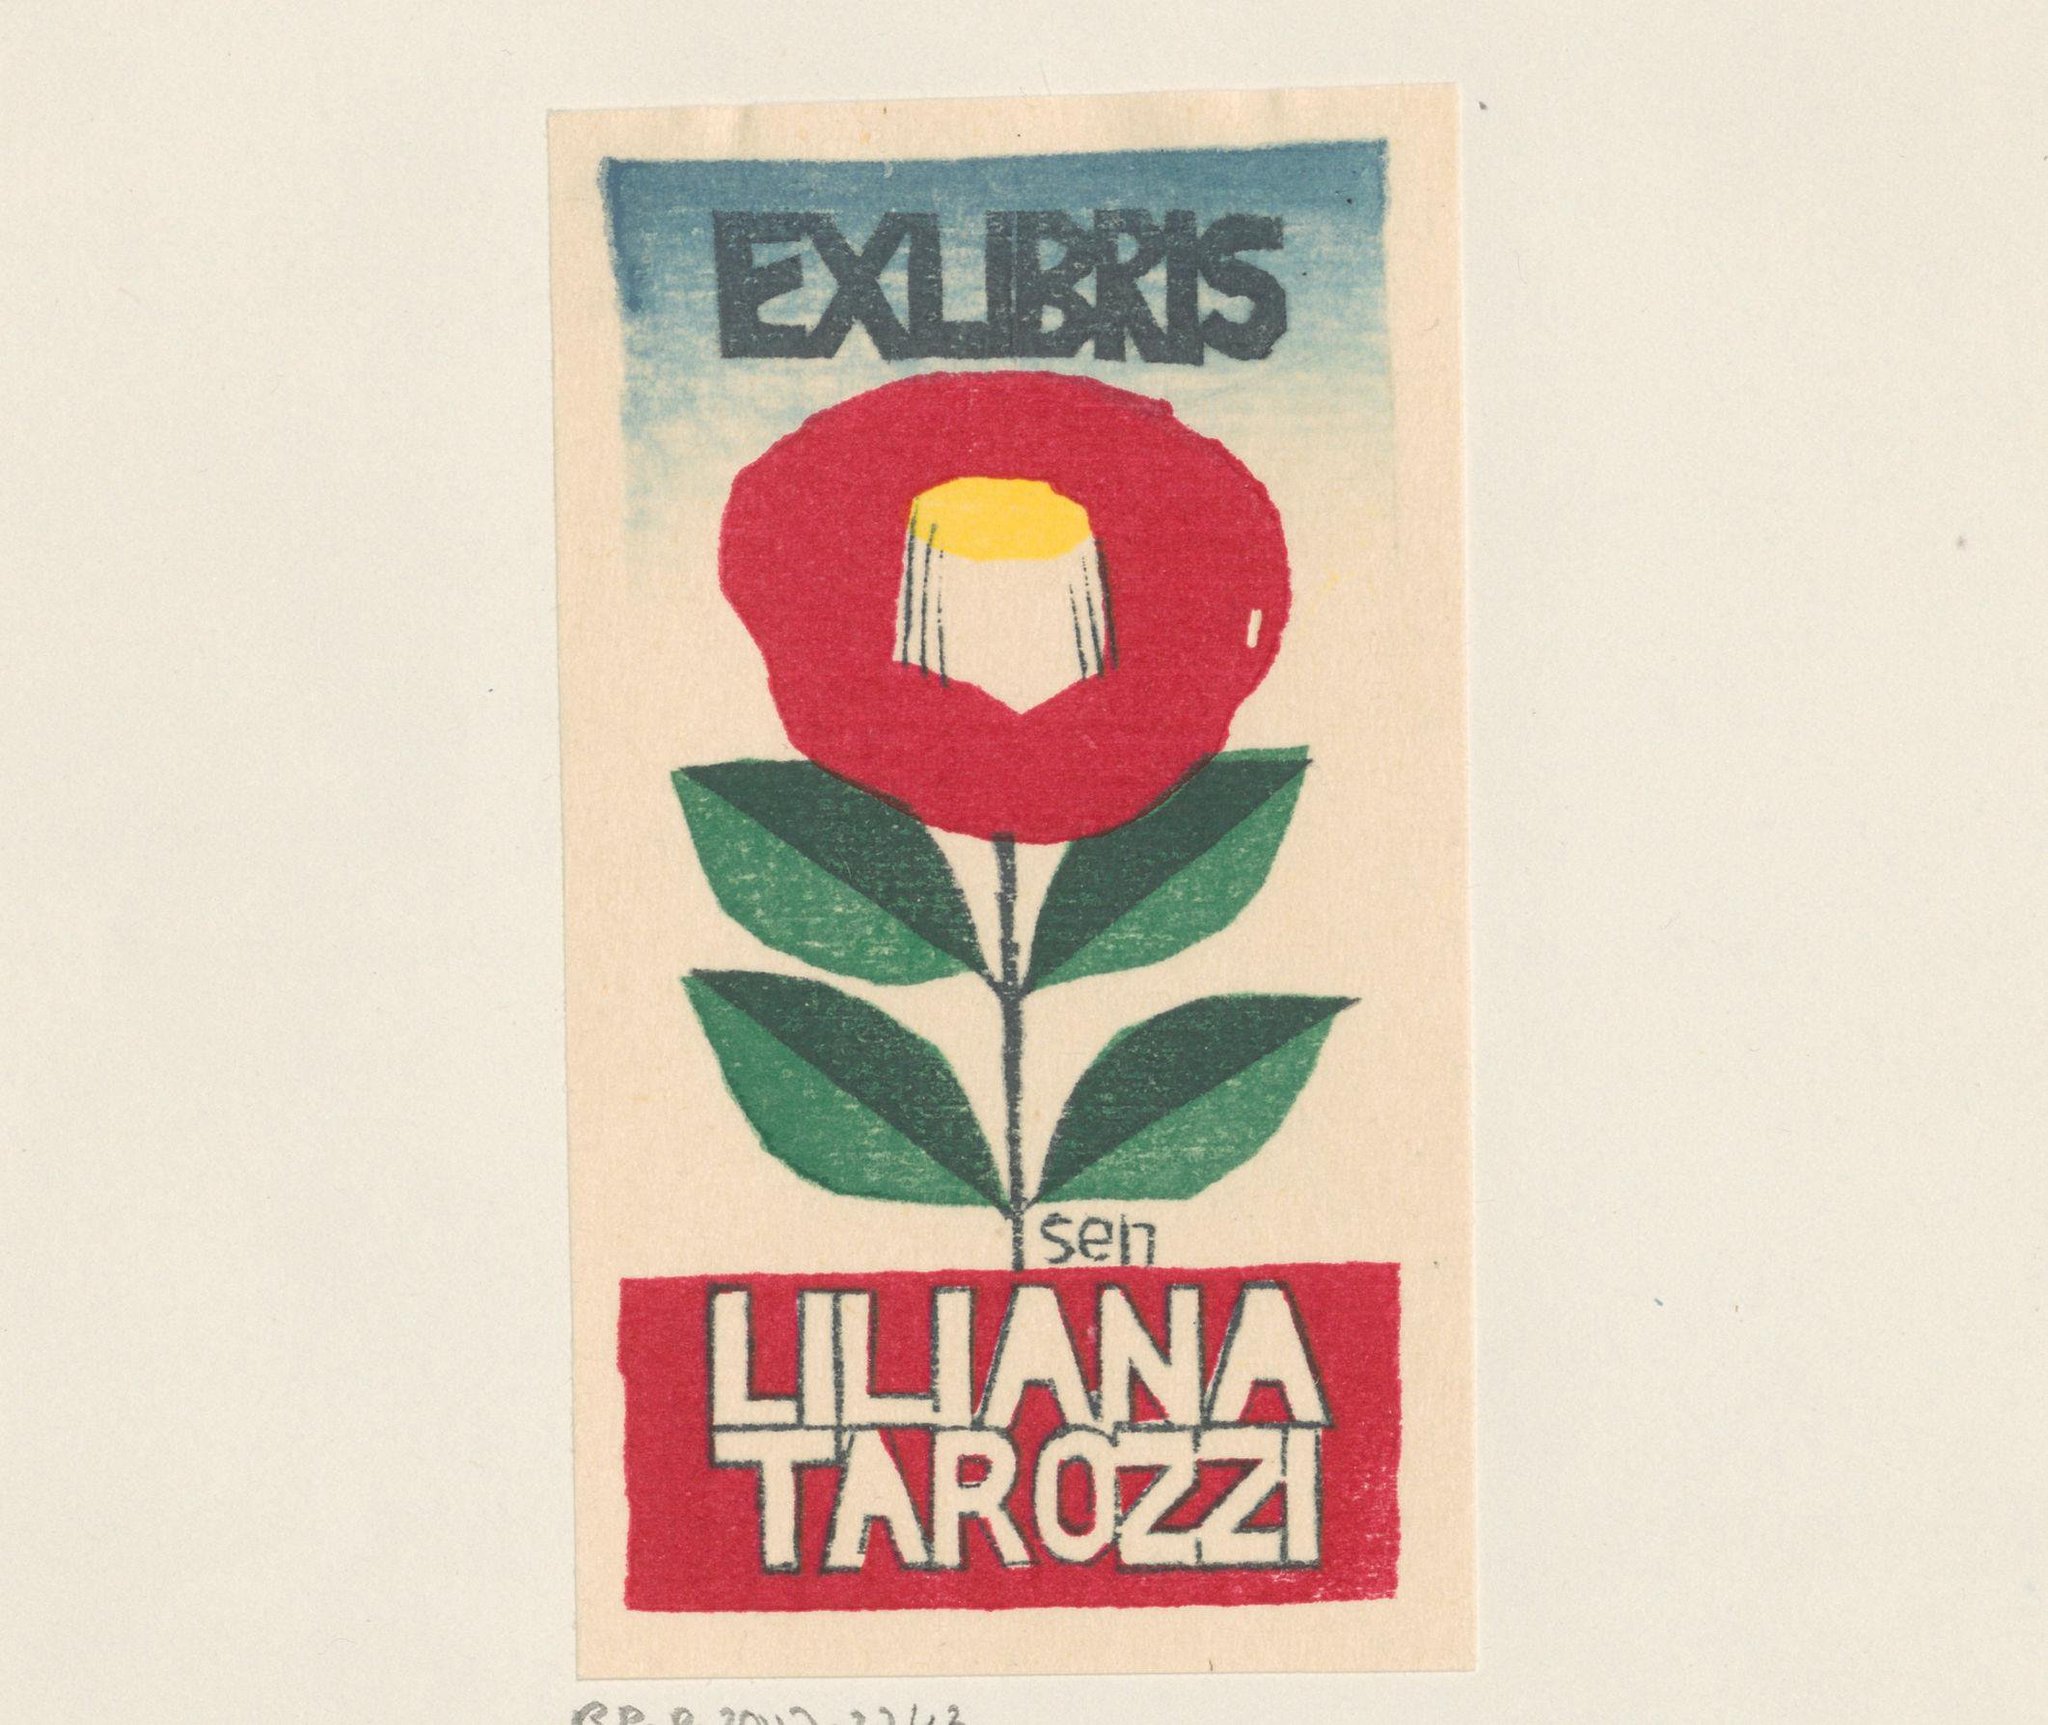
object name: bookplate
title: Ex libris van Liliana Tarozzi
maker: Anonymous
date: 1900-1999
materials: paper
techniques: woodcut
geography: japan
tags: flowers